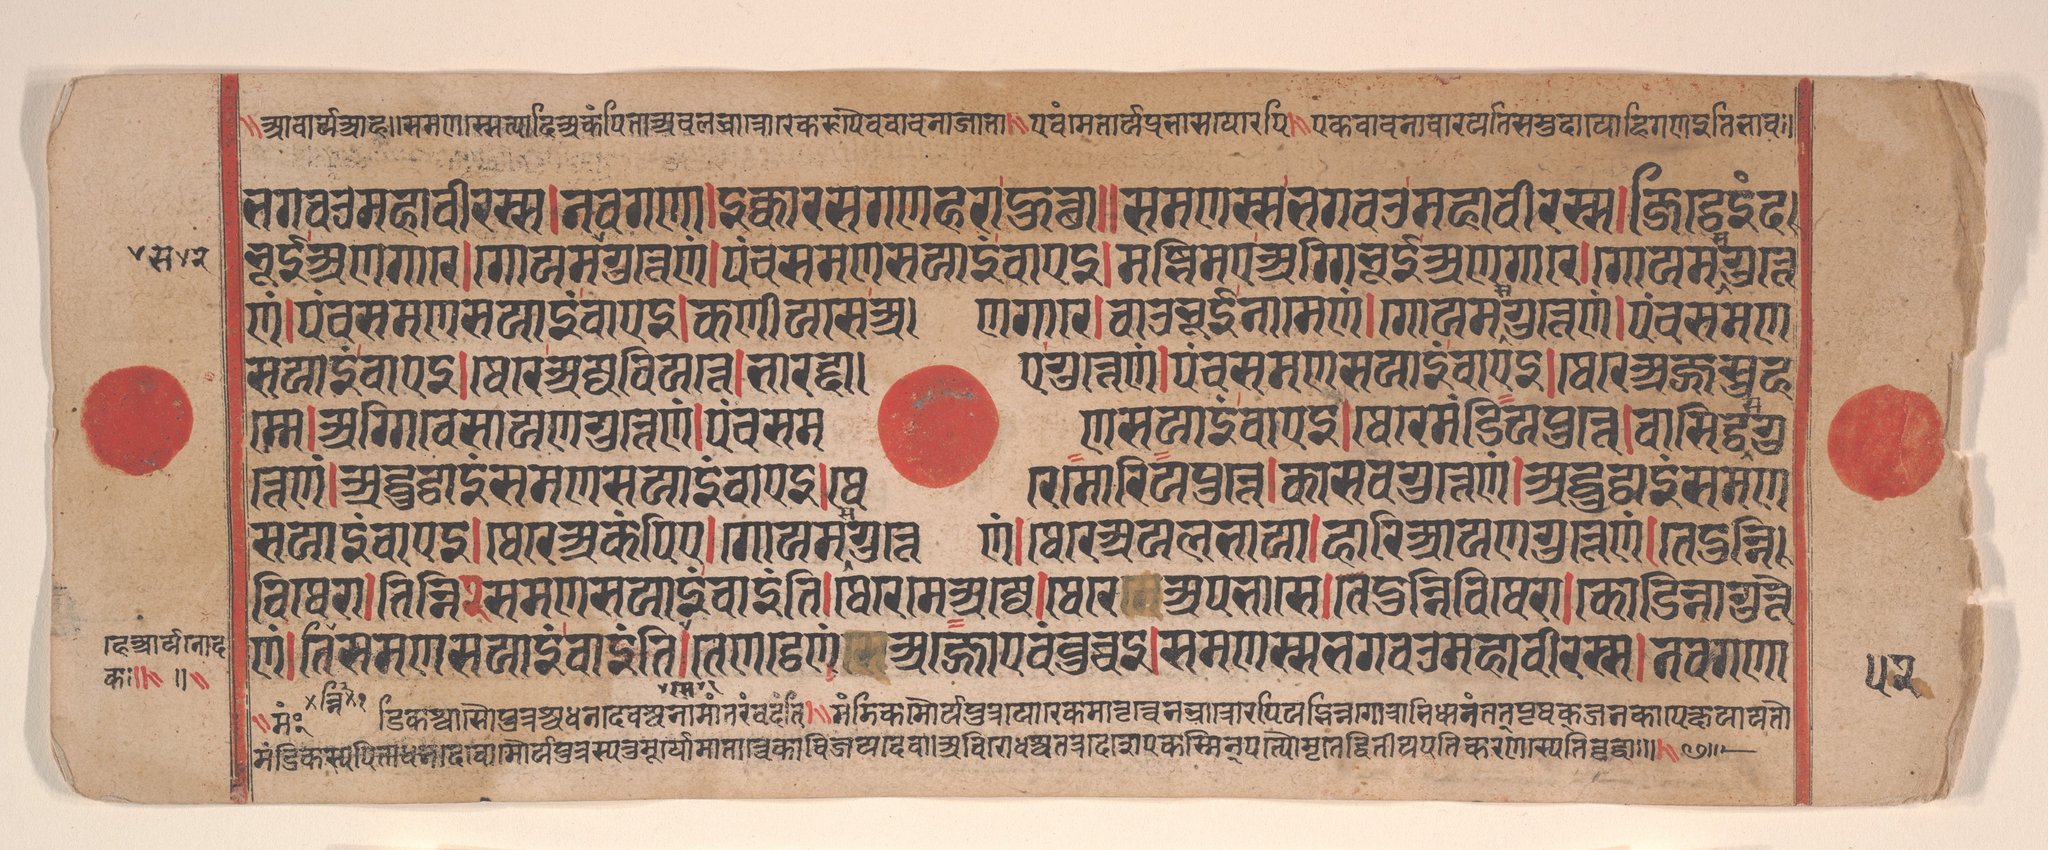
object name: folio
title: Leaf from a Kalpa Sutra (Jain Book of Rituals)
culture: indian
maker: bhadrabahu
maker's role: artist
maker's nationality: indian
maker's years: 356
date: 1401-1500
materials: gold, ink, paper, watercolor